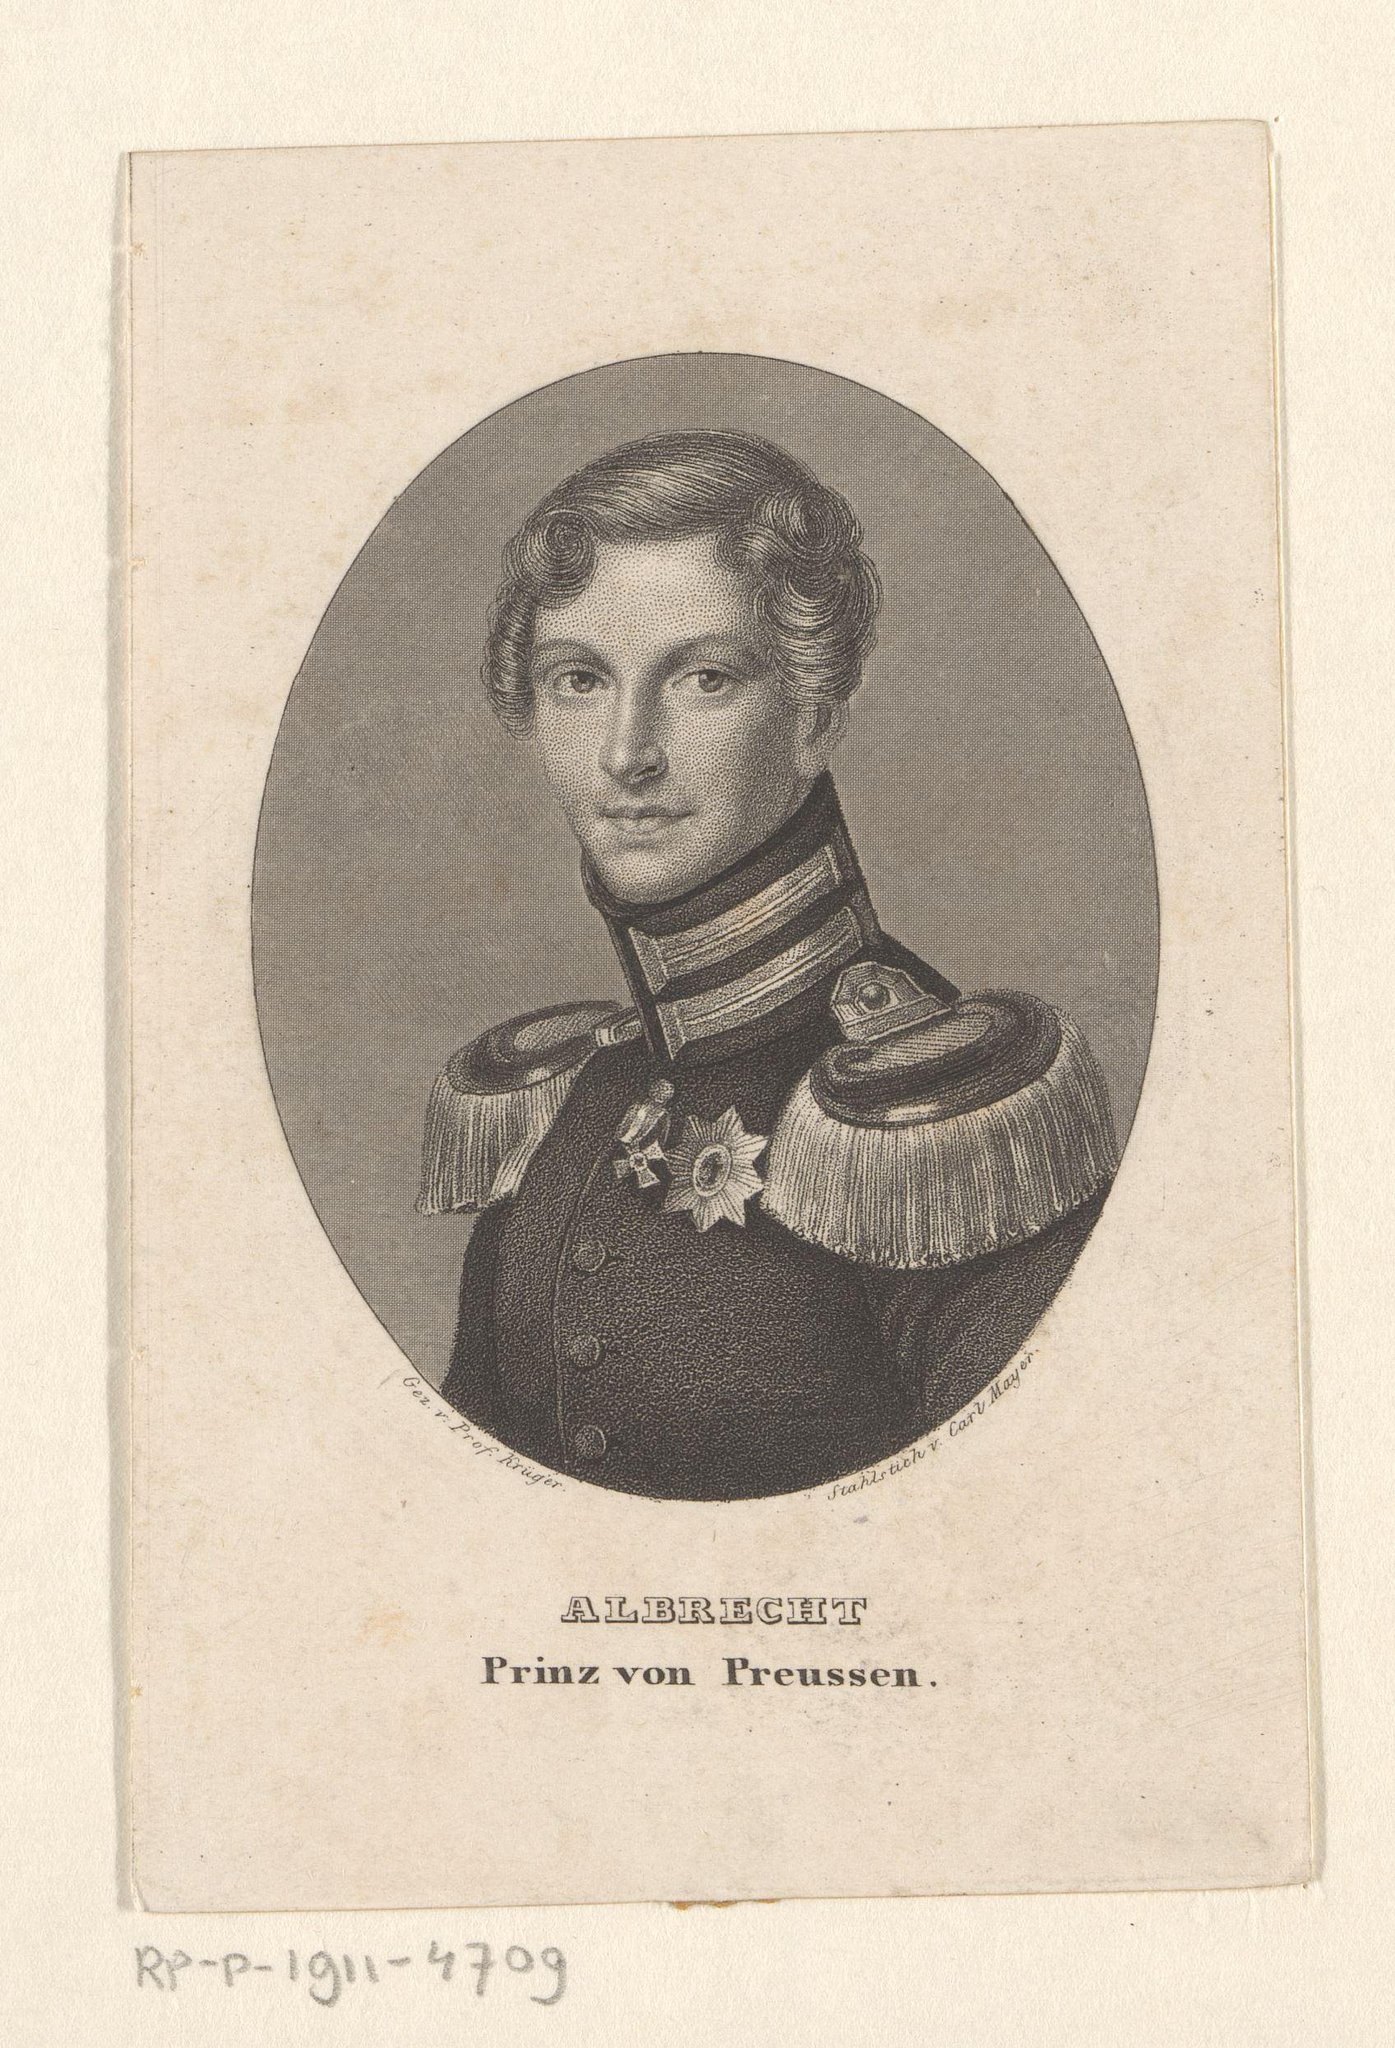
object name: print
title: Portret van Albert van Pruissen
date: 1809-1868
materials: paper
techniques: engraving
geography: nuremberg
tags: berlin, historical persons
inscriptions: collector's mark: Lugt 2228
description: Prent mogelijk afkomstig uit de Almanach de Gotha.